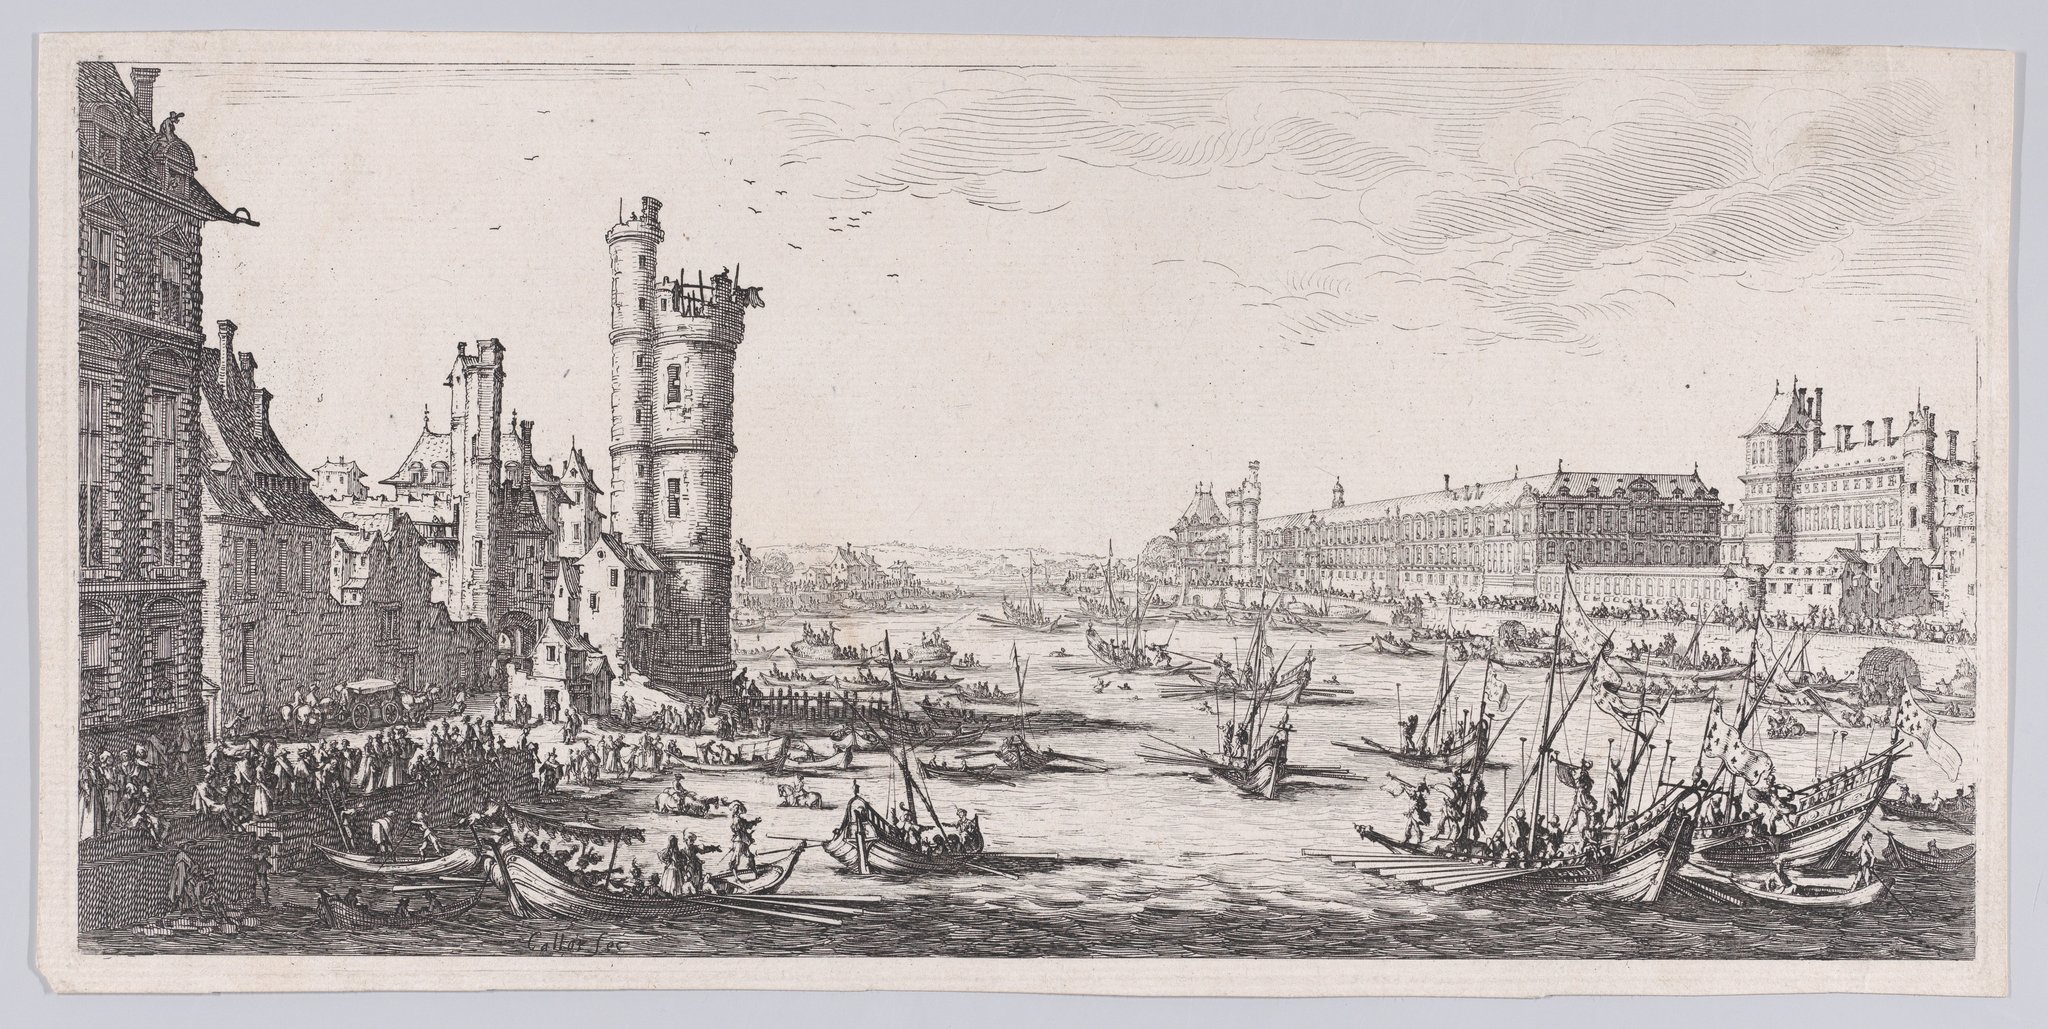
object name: print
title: Vue du Louvre (View of the Louvre), from "Les Deux Grandes Vues de Paris" (The Two Large Views of Paris)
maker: jacques callot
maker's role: artist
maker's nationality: french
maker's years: 1592-1635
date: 1630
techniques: etching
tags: towers,rivers,boats,paris